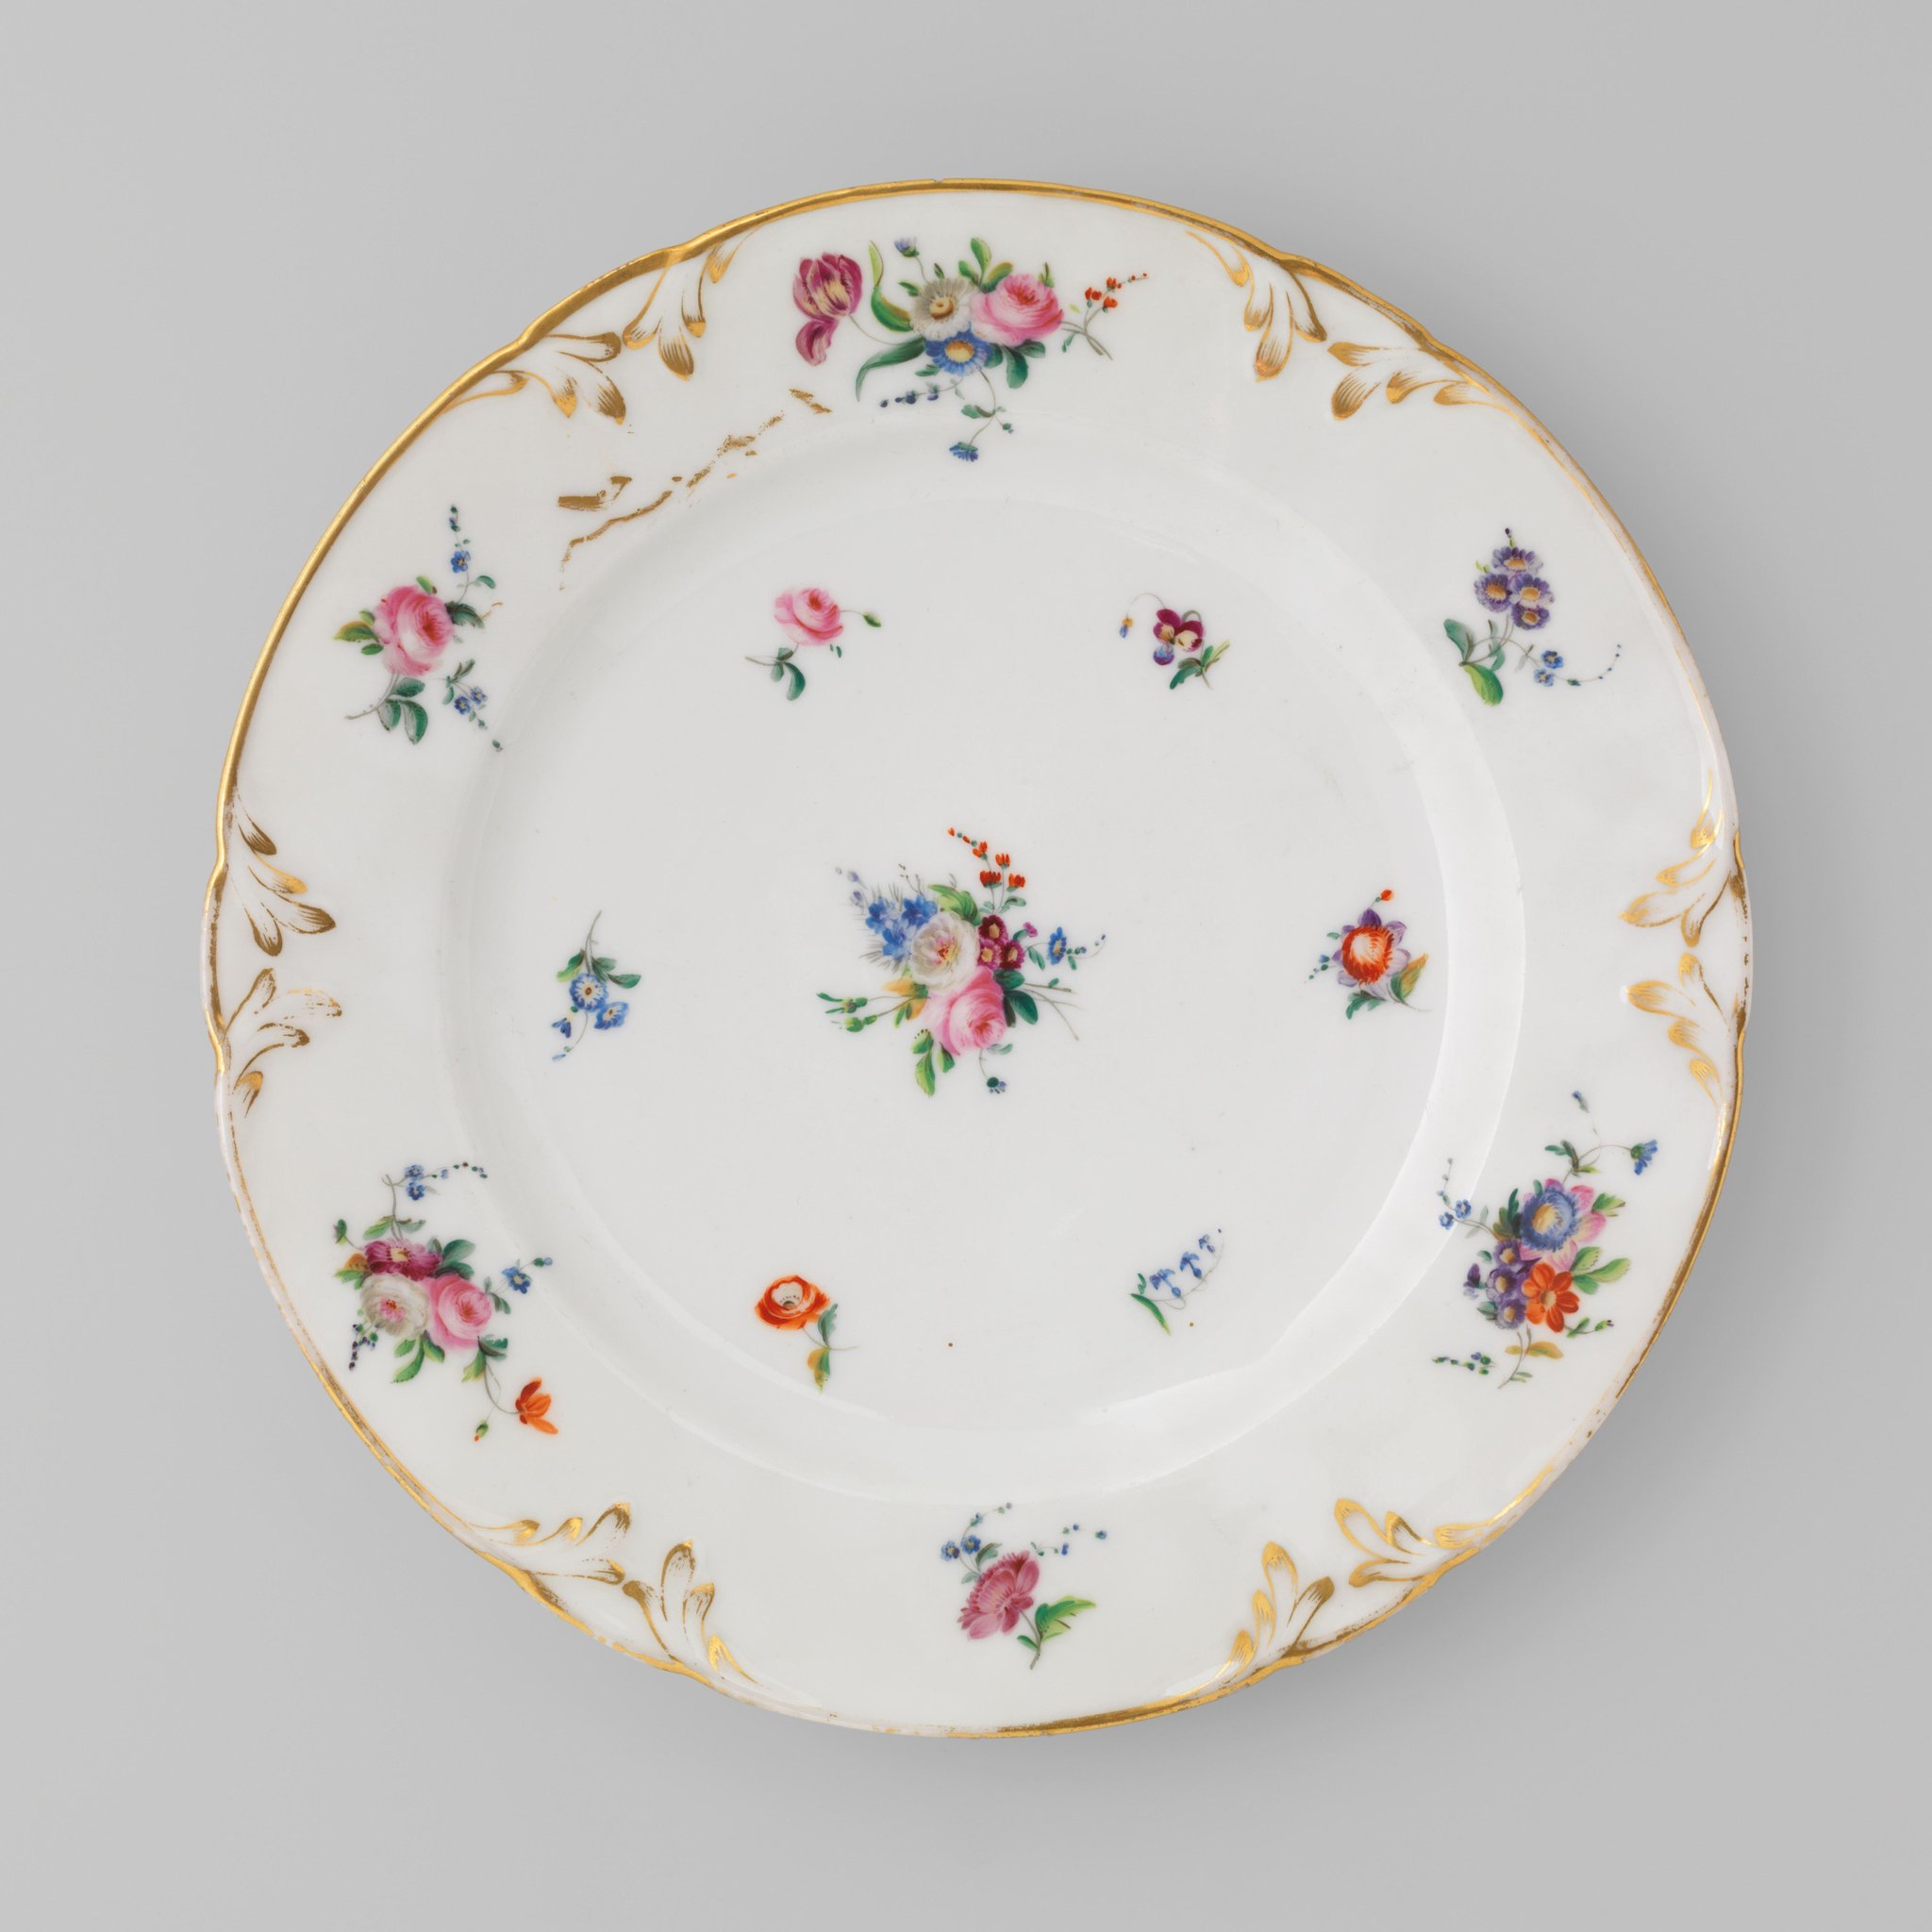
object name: plate dish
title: Plate with bouquets and flower sprays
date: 1839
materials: glaze, gold, paint, porcelain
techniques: firing, forming, gilding, turning, vitrification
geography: paris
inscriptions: mark: ‘DENUELLE/ Boulevard St. Denis 18/ à Paris’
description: Bord (dessertbord) van porselein met een gelobde rand, beschilderd op het glazuur in blauw, rood, roze, groen, geel, paars, zwart en goud. Op het plat boeketten van verschillende bloemen en strooibloemen. Vanuit de gelobde, gouden rand, gemodelleerde bladranken in reliëf, aangezet met goud. Hiertussen boeketten. Drie proenen op de onderzijde. Gemerkt op de onderzijde met 'DENUELLE/ Boulevard St. Denis 18/ à Paris'.